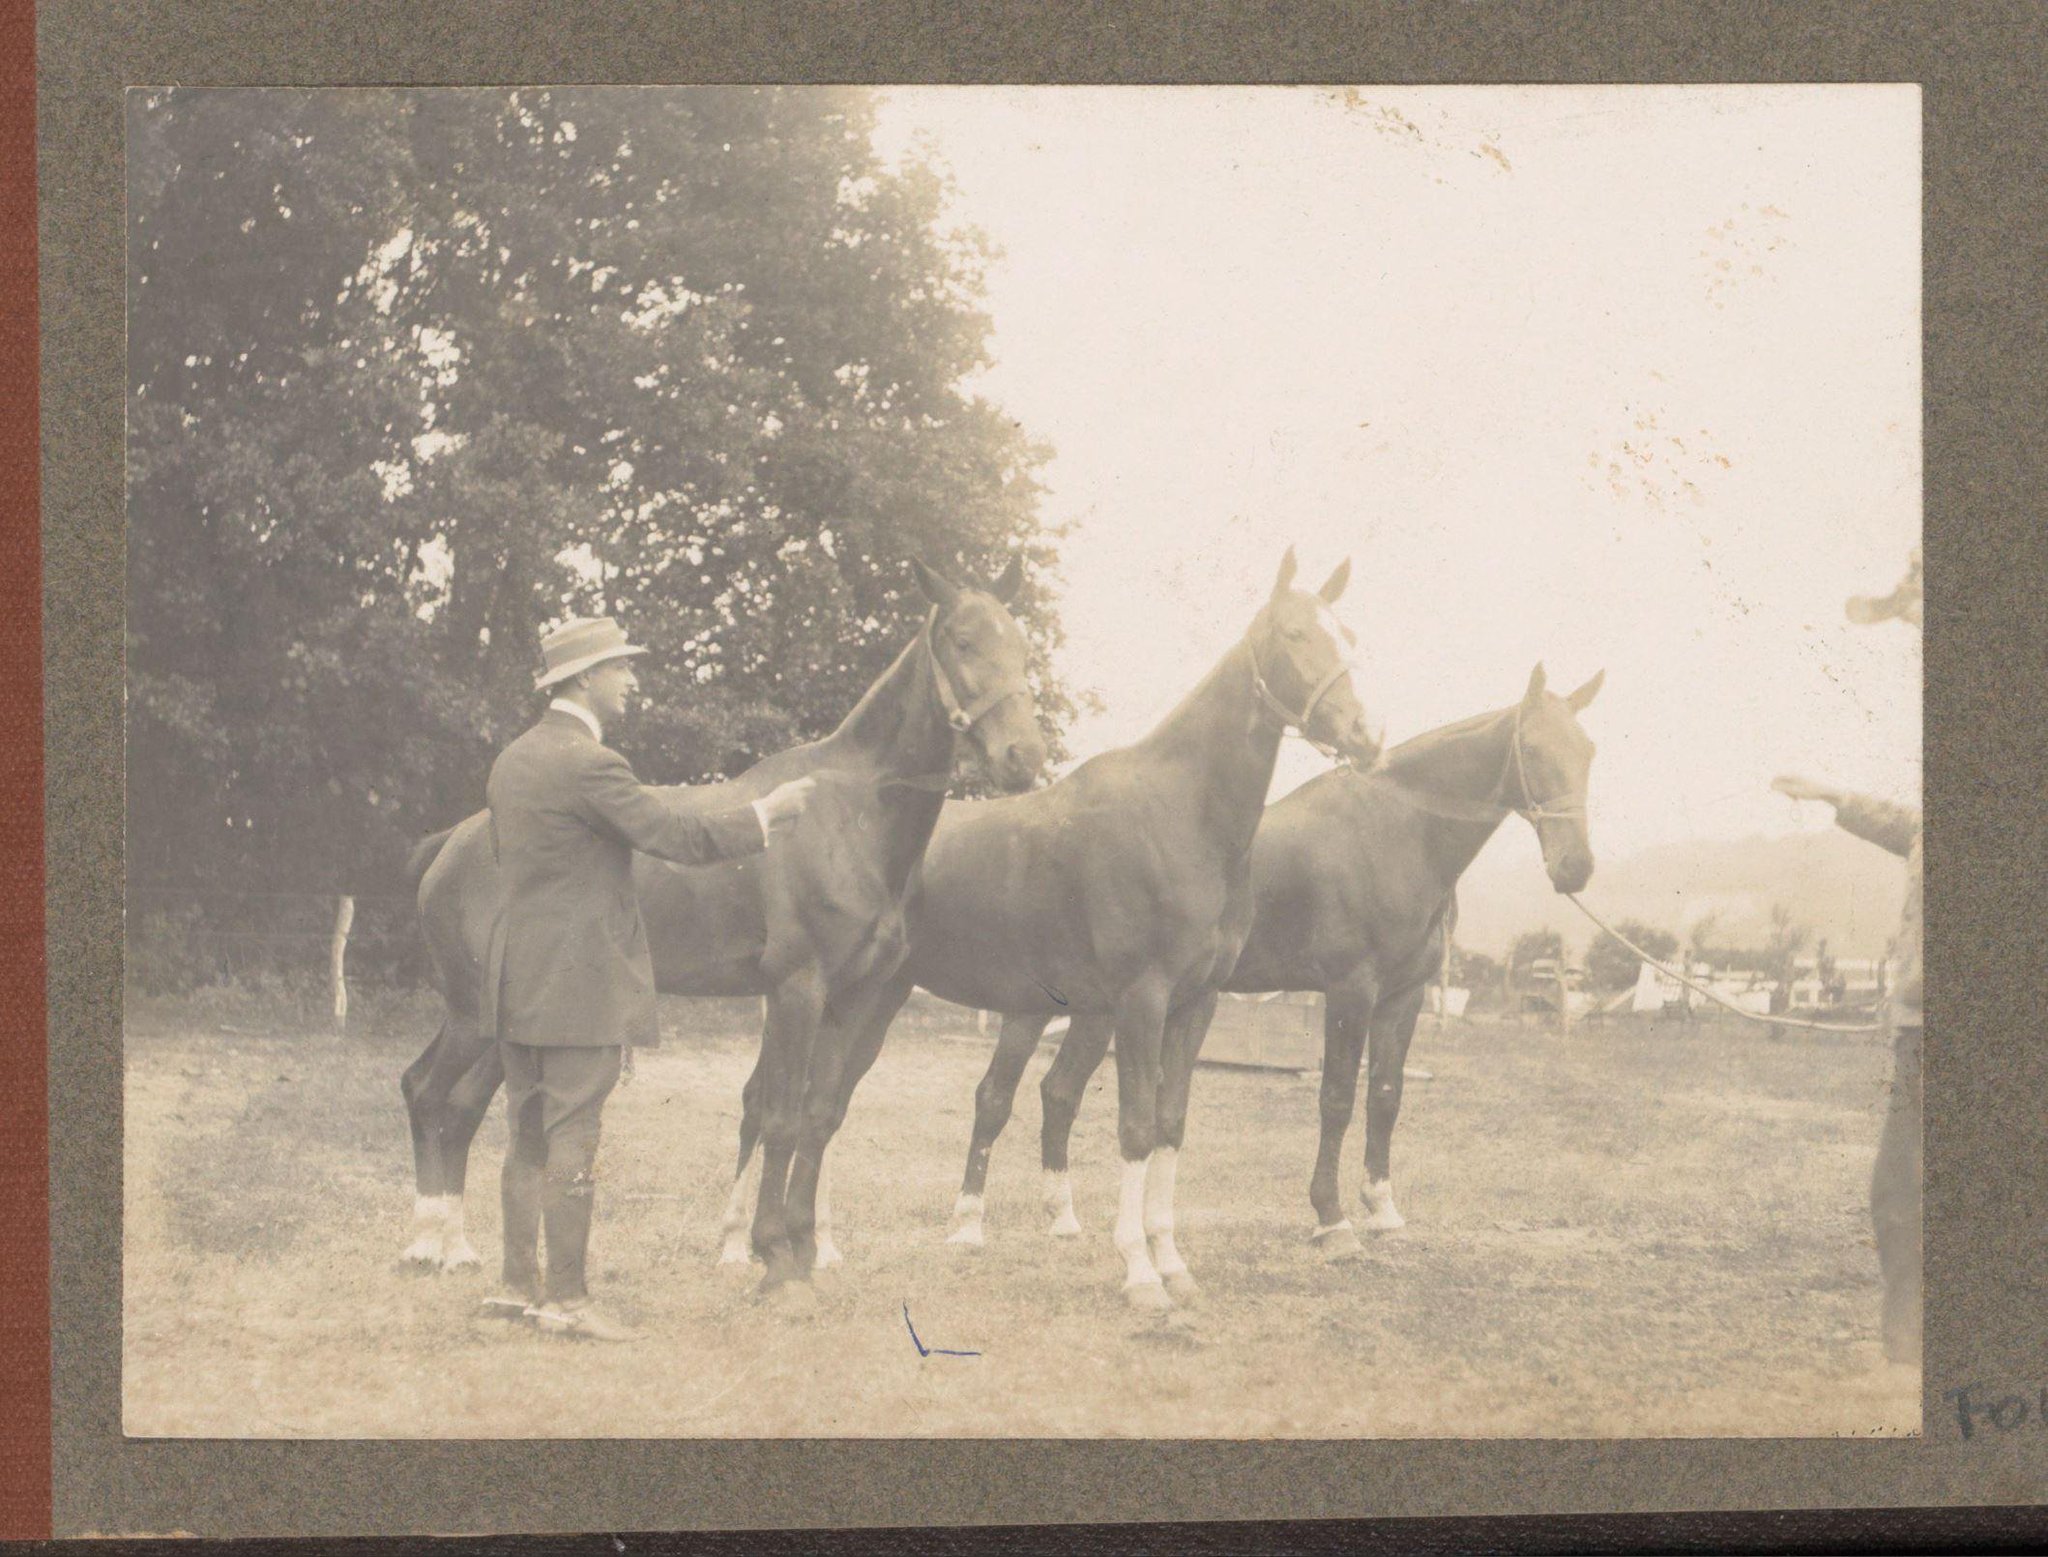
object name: photograph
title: Ruitertafereel op Koninklijke Houtvesterij Het Loo: man met drie ongezadelde paarden in een weiland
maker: Anonymous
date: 1900-1925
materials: photographic support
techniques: gelatin silver print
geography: het loo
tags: hunting, chase, hunting-ground, horse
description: Onderdeel van Fotoalbum van de heer Brams, opperhoutvester van koningin Wilhelmina op Koninklijke Houtvesterij Het Loo.